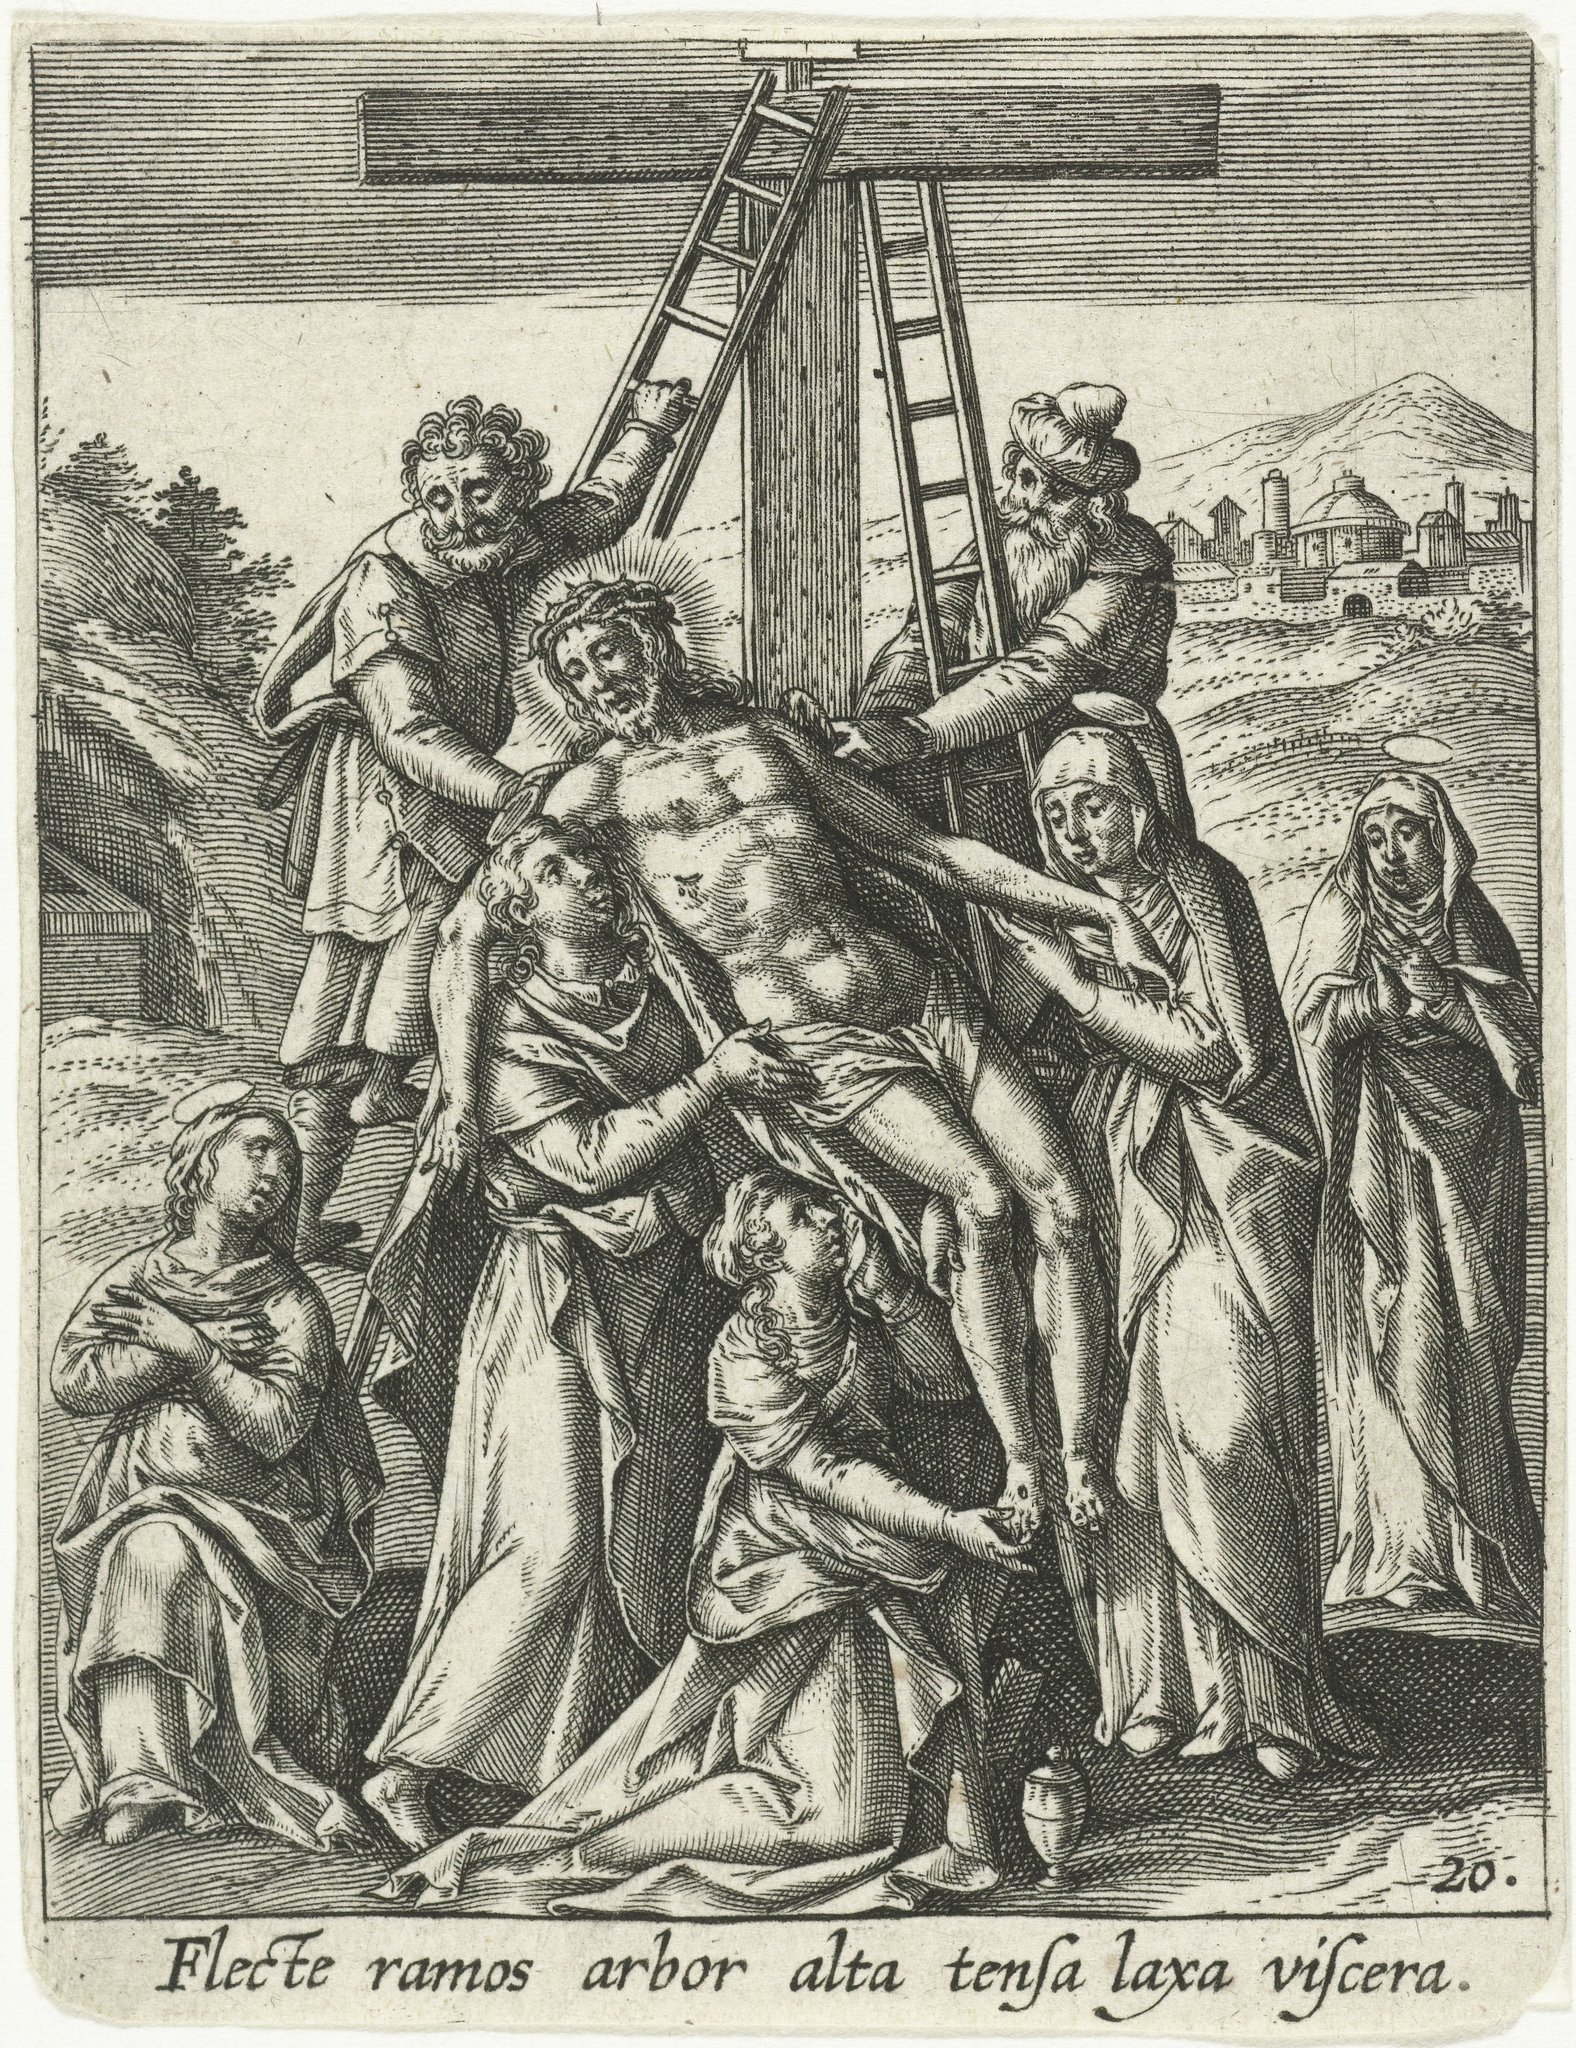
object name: print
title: Passie en wederopstanding van Christus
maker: adriaen collaert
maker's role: draughtsman, print maker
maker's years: 1560-1618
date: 1570-1618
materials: paper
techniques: engraving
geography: antwerp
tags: descent from the cross: christ is taken down from the cross, usually by nicodemus and joseph of arimathaea who are standing on the ladders (both arms of christ detached)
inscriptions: collector's mark: Lugt 240, collector's mark: Lugt 2228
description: Christus wordt het kruis afgenomen door Jozef van Arimatea en Nikodemus. Maria, Maria Magdalena en drie andere vrouwen helpen. De prent heeft een Latijns onderschrift